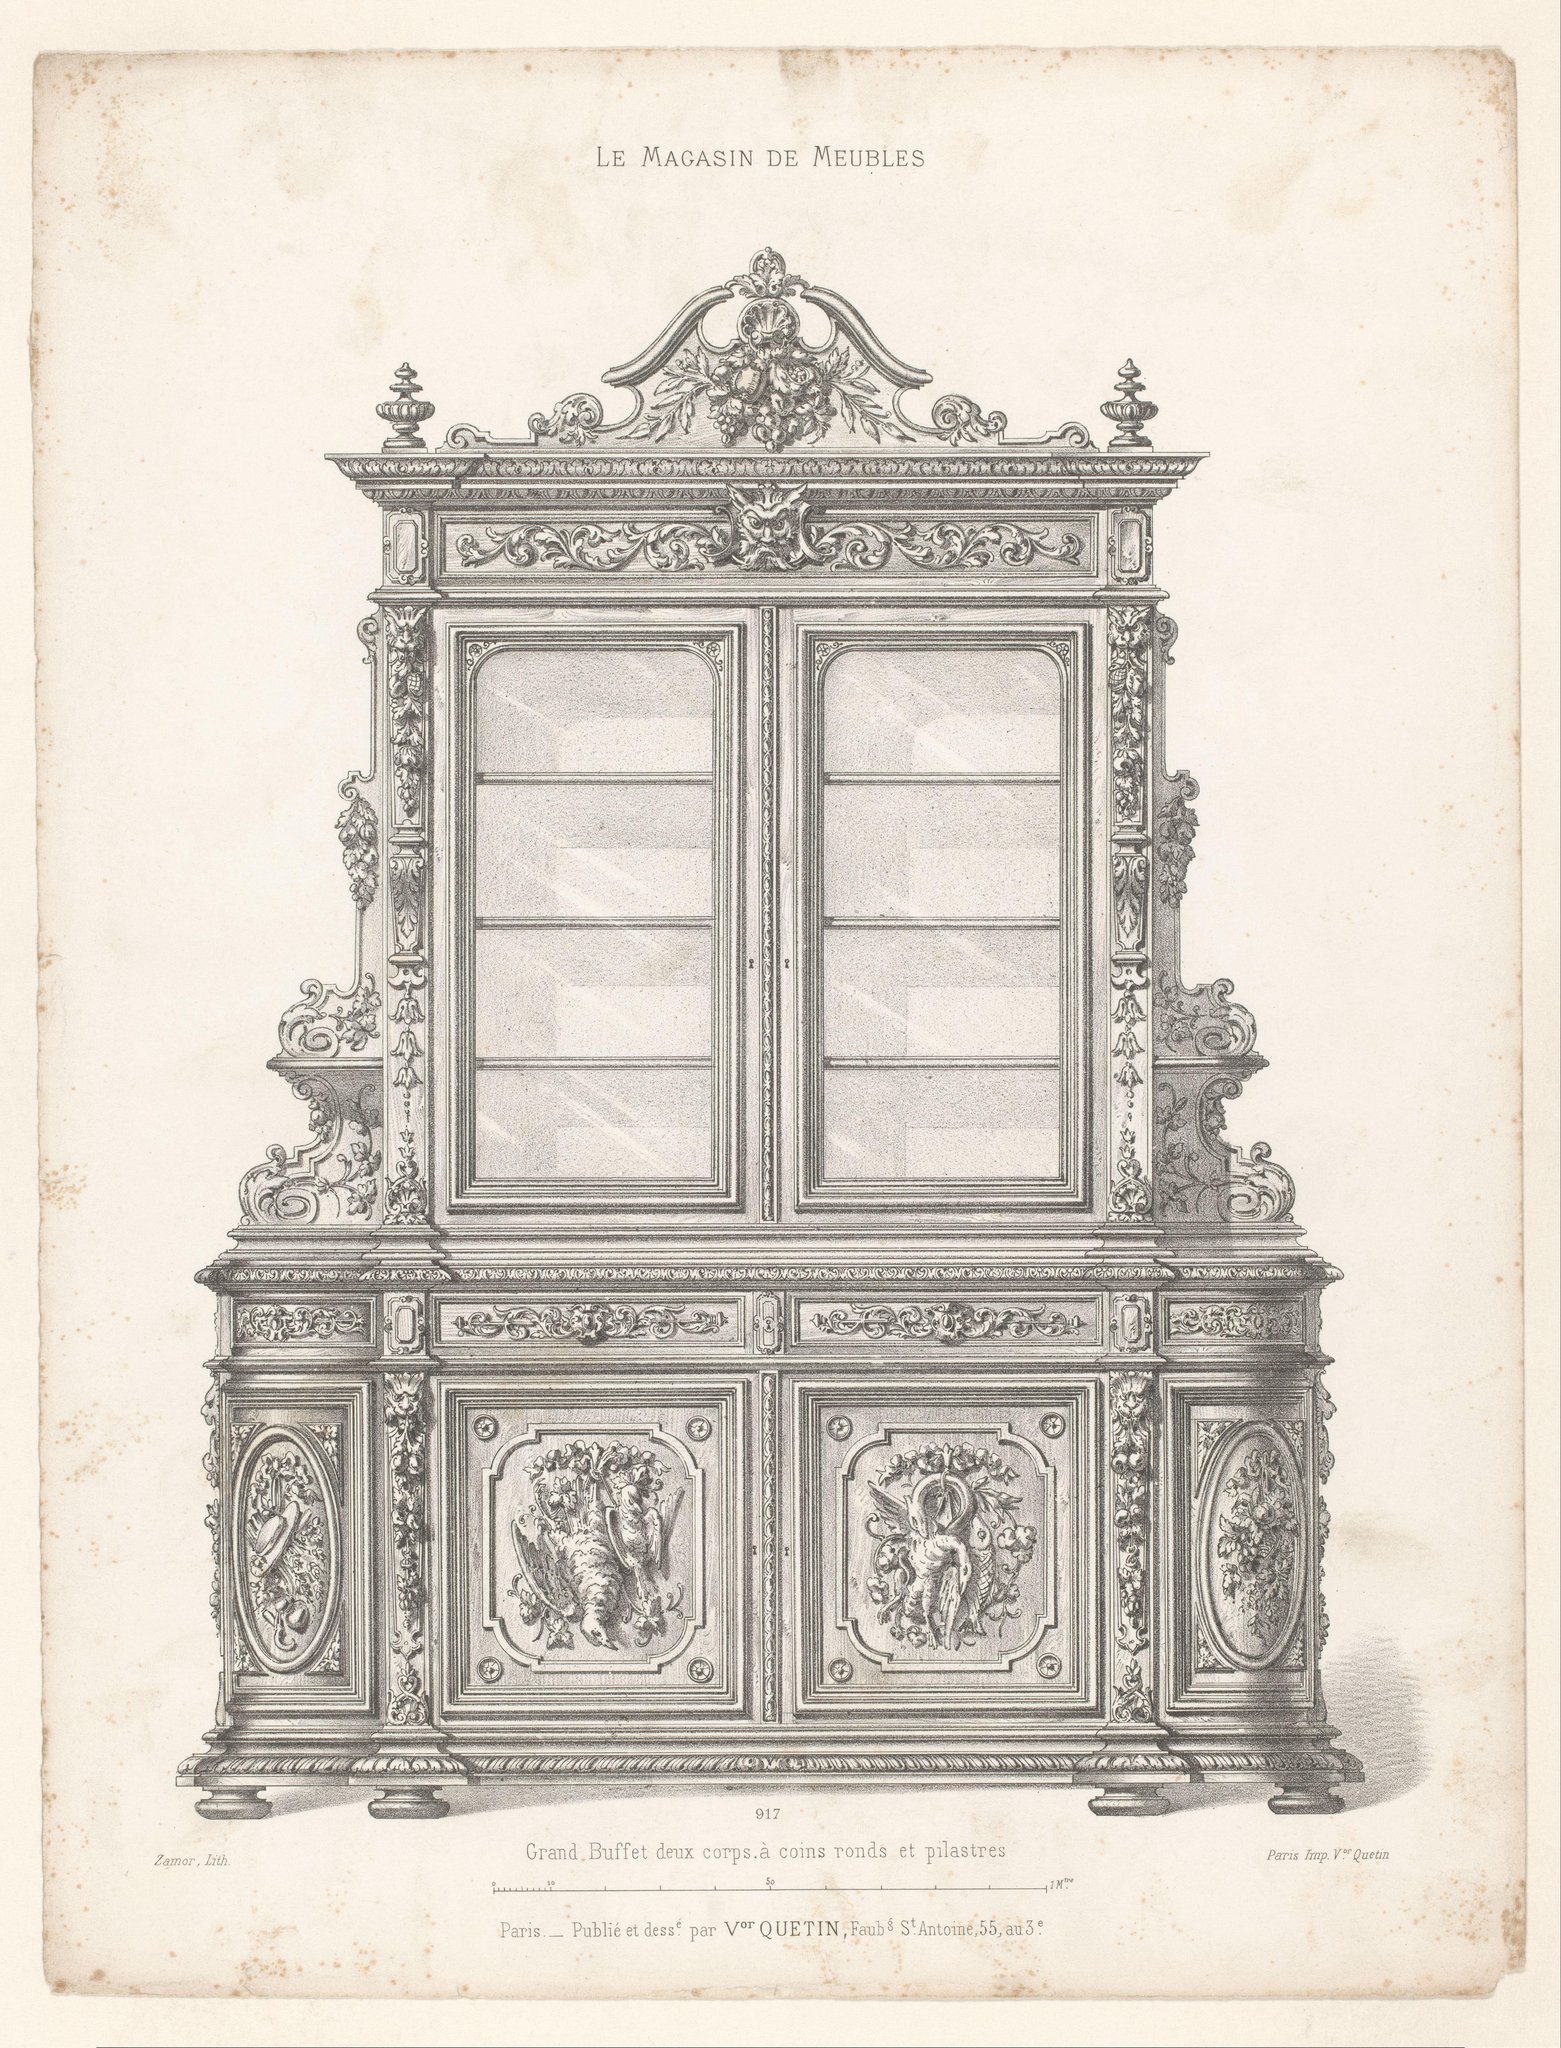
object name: print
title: Le Magasin de Meubles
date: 1832-1877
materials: paper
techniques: lithograph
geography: paris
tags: furniture for storage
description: Een buffetkast met geornamenteerde jachttrofeeën.